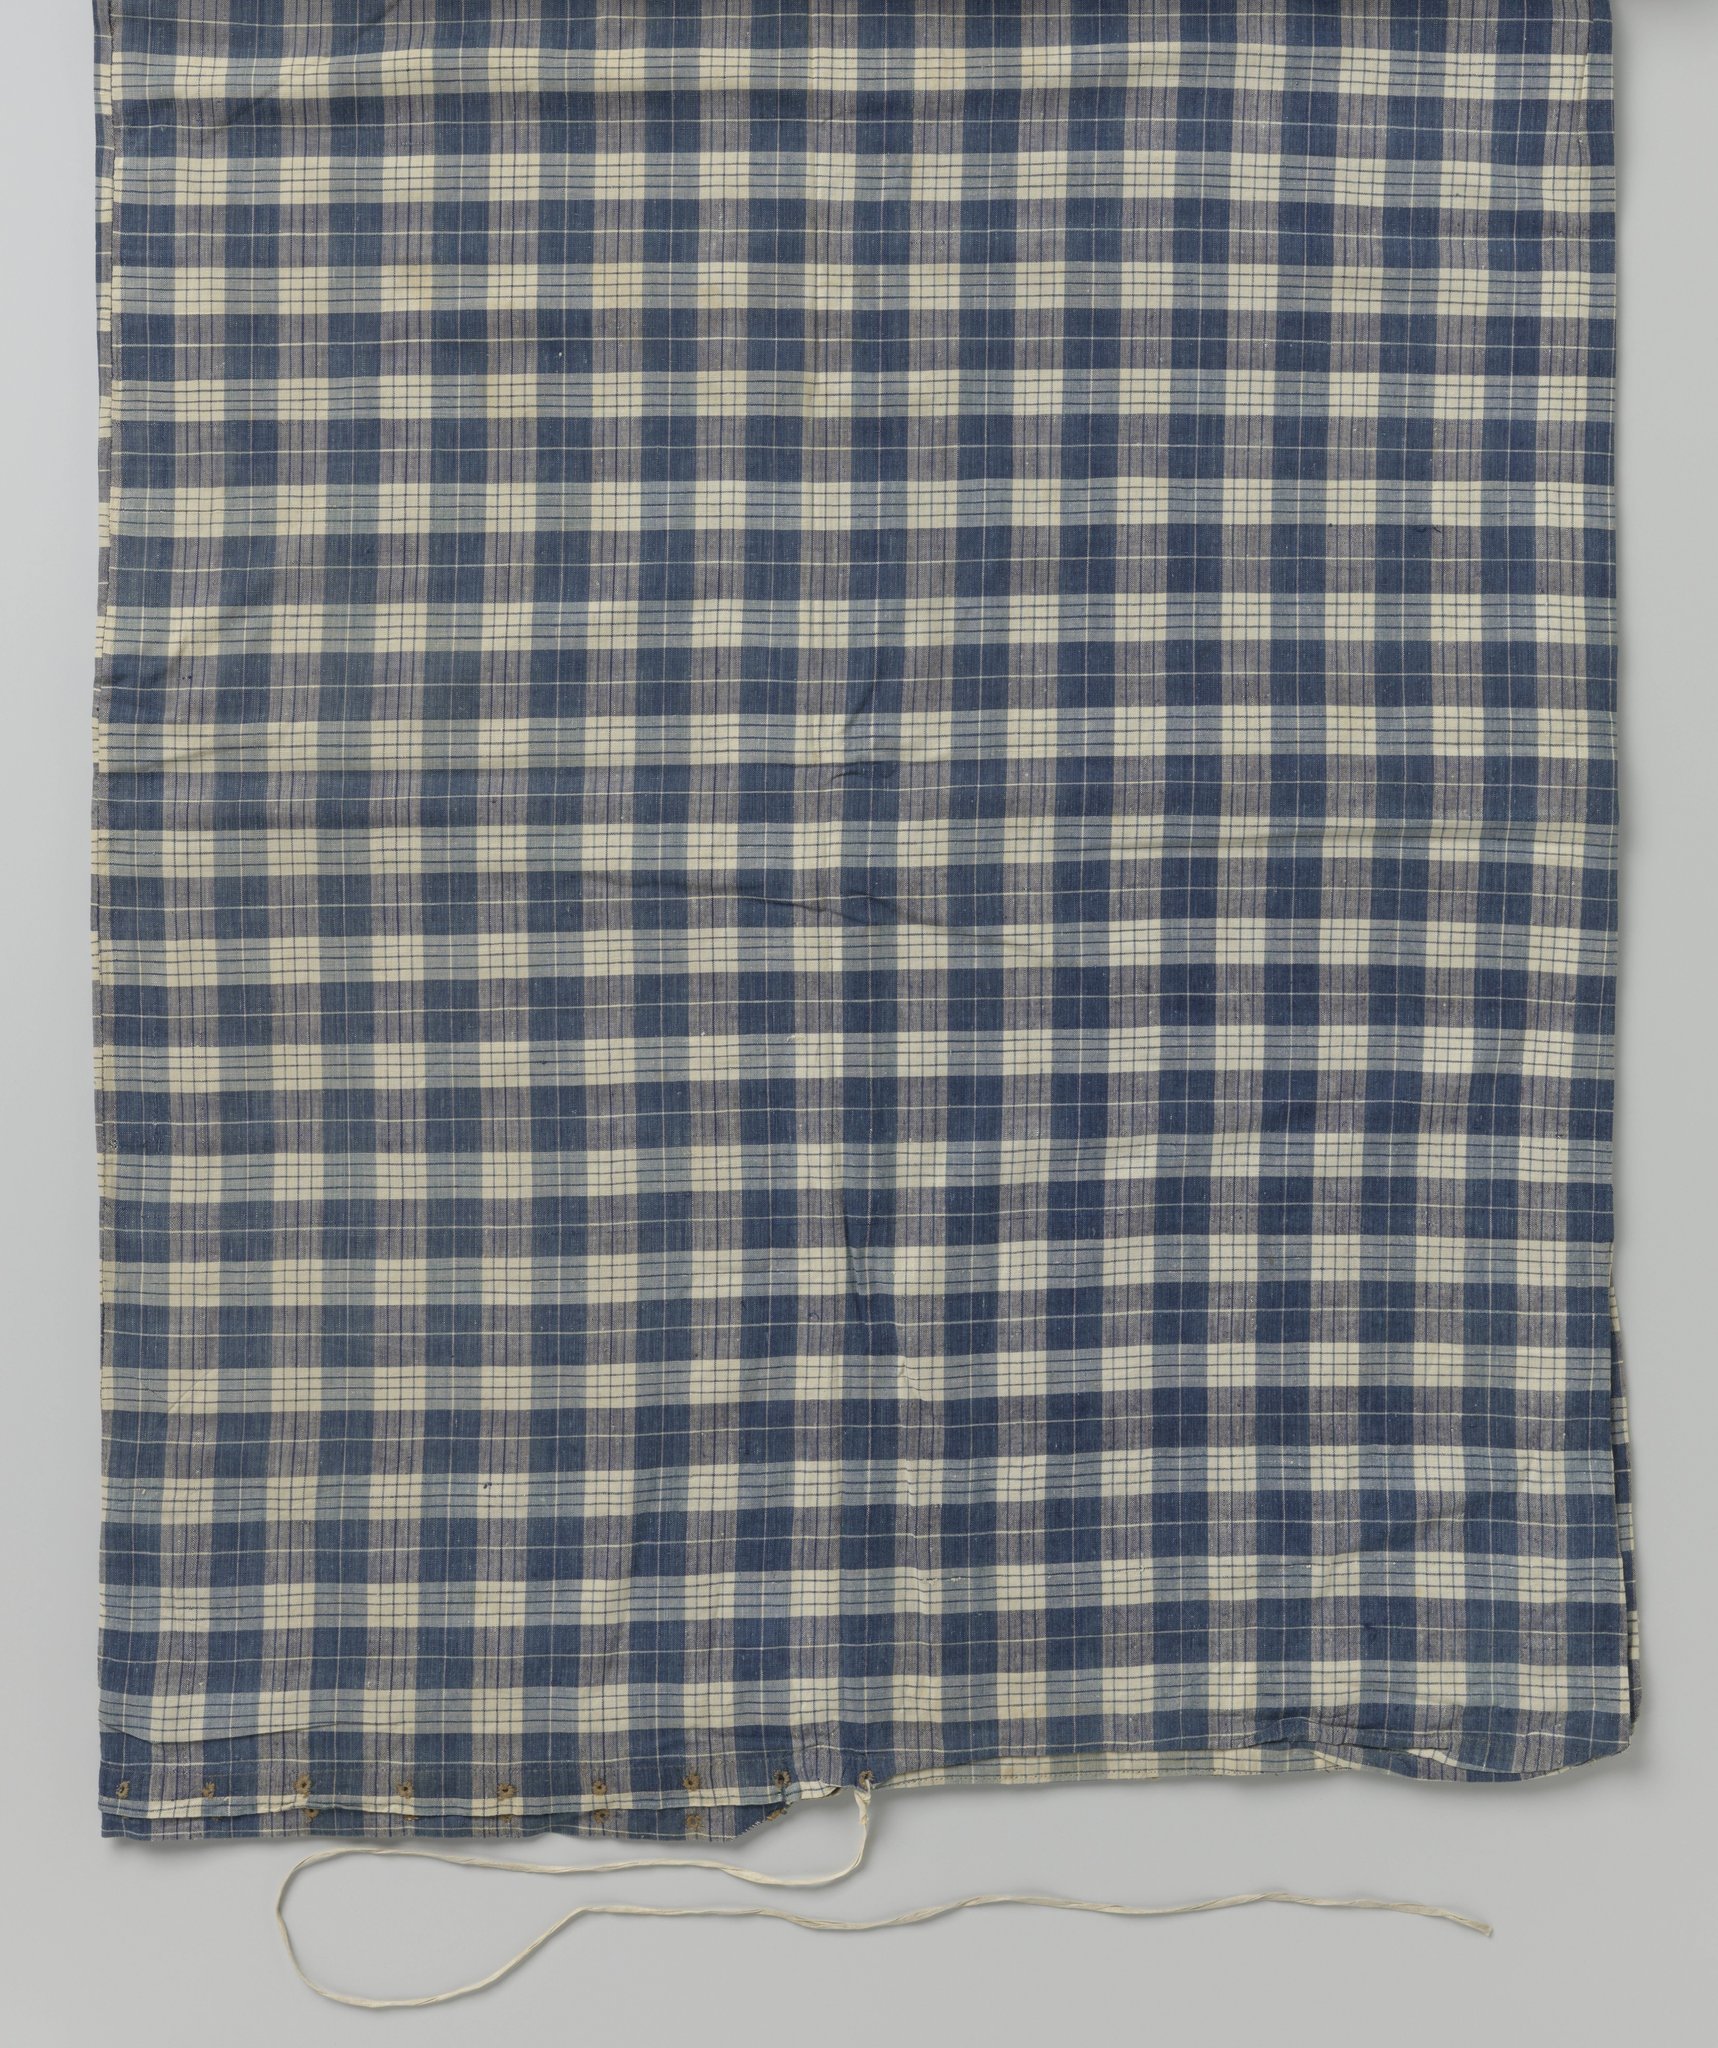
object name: tick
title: Bedovertrek van tijk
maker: Anonymous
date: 1800-1950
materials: cotton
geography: europe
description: Tijken bedovertrek, blauw-wit geblokt en gestreept.